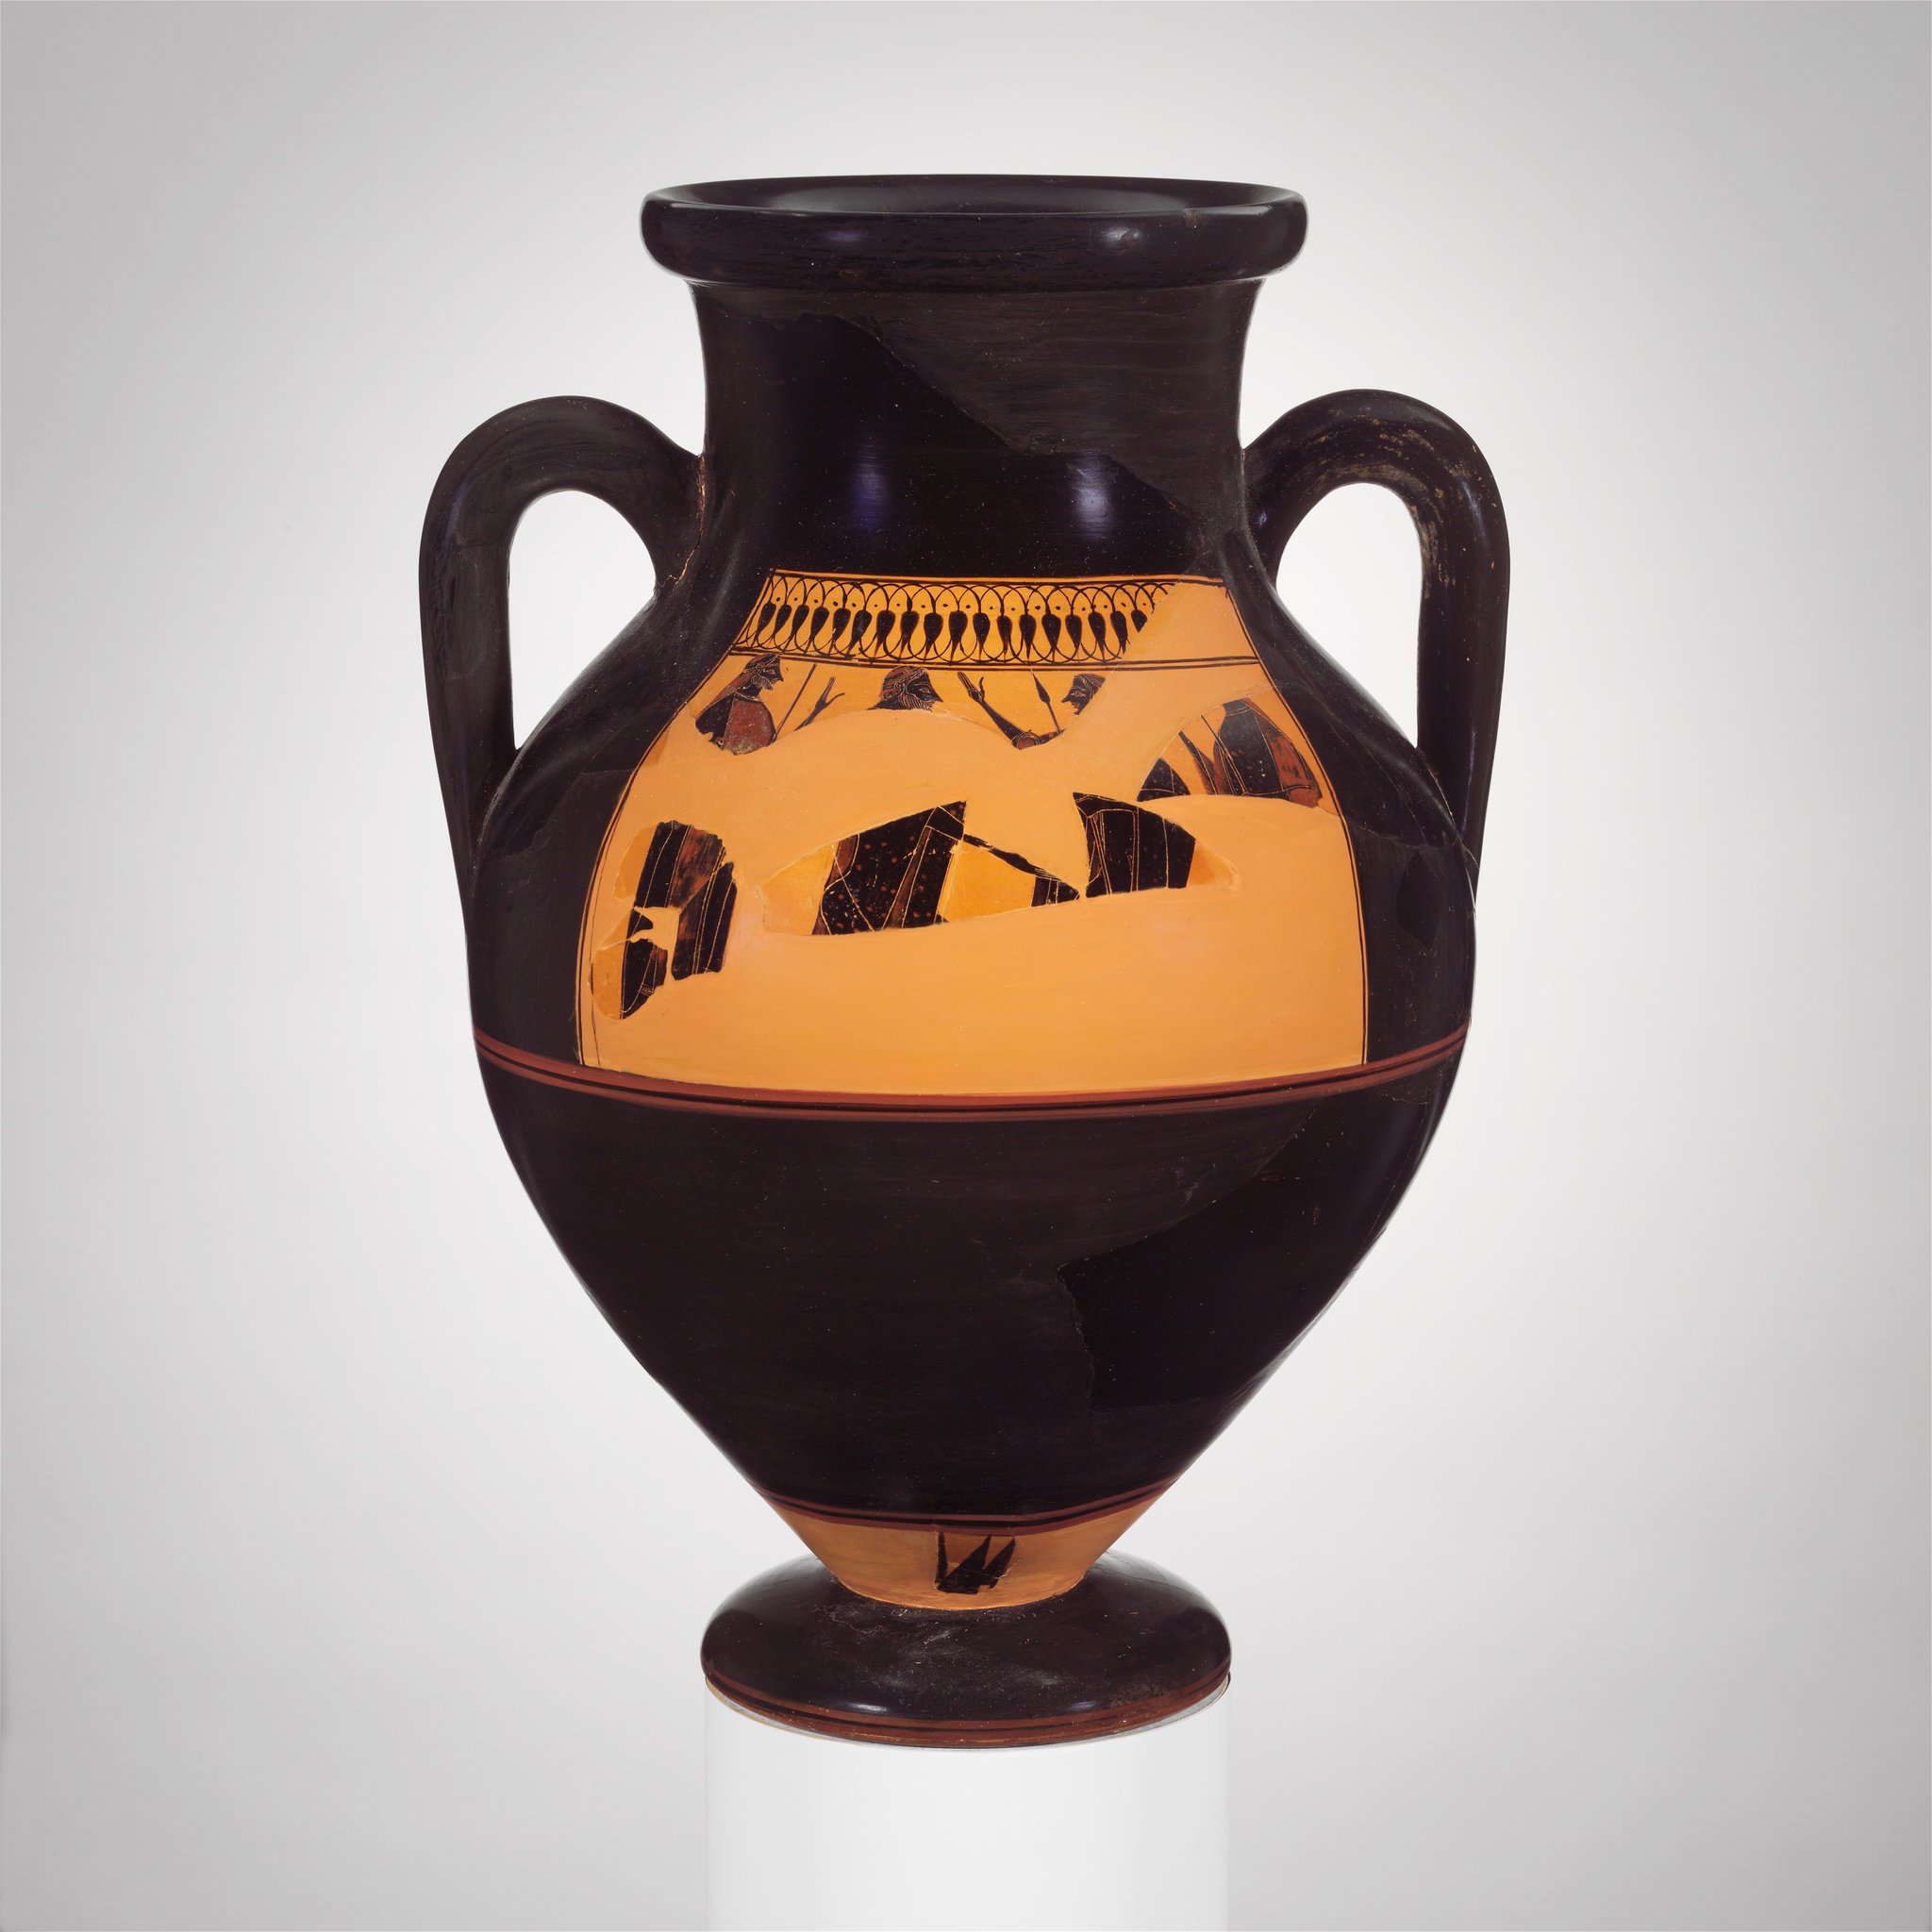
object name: amphora, type c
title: Terracotta amphora (jar)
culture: greek, attic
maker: affecter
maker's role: artist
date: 540 BCE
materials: terracotta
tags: men